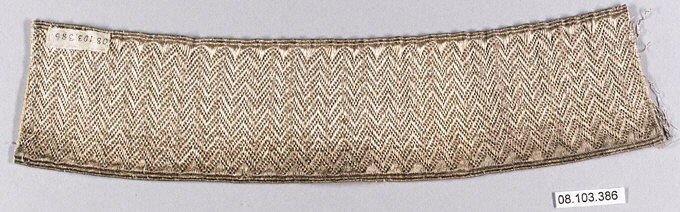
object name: galloon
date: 1601-1800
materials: metal thread